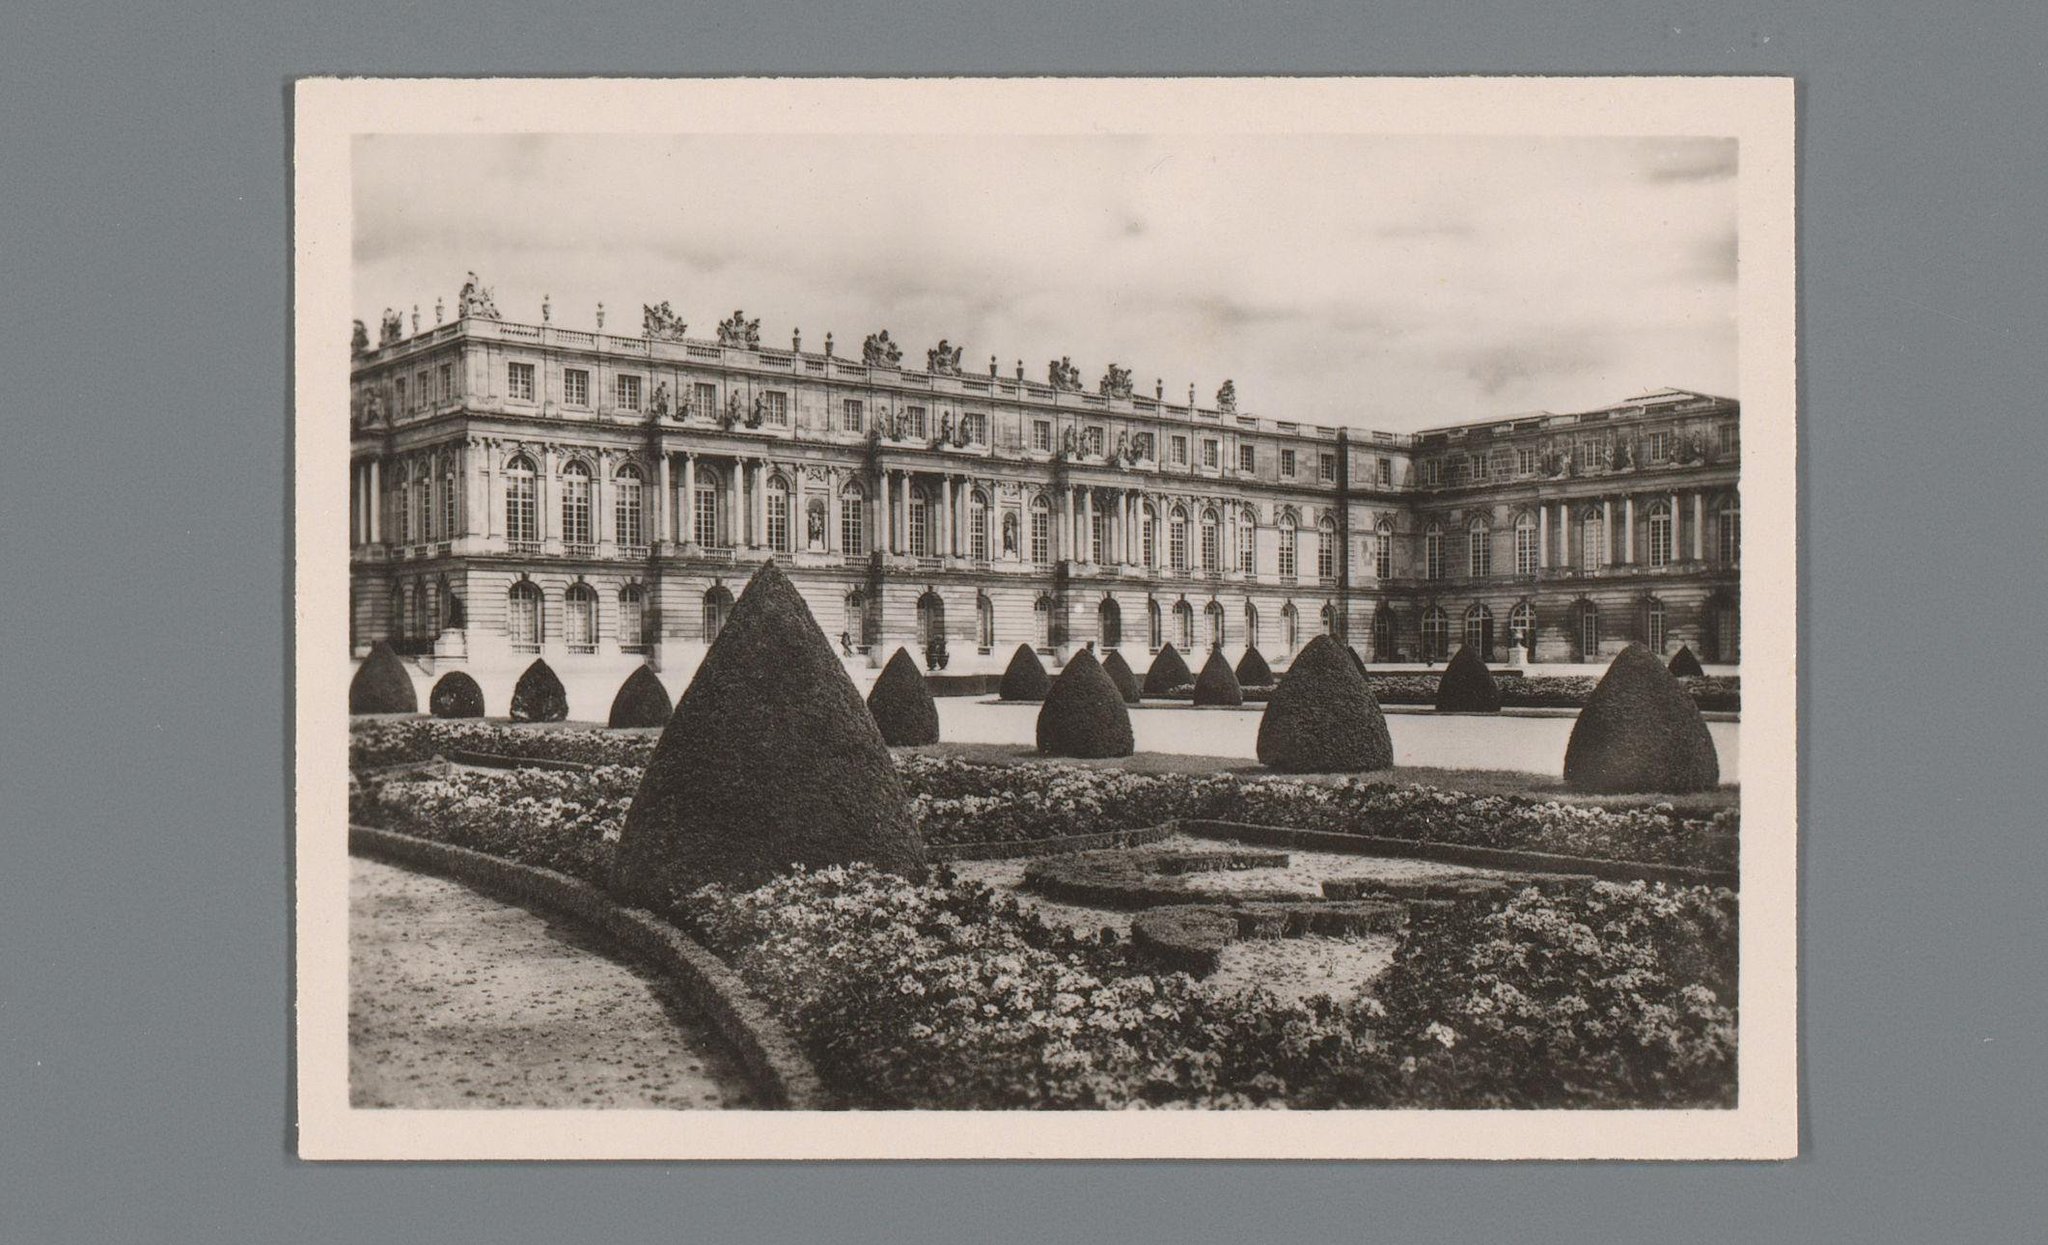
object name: photograph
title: Gezicht op het Kasteel van Versailles vanuit de tuinen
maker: Anonymous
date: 1900-1920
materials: paper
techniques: gelatin silver print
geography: versailles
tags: palace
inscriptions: number: ‘10’